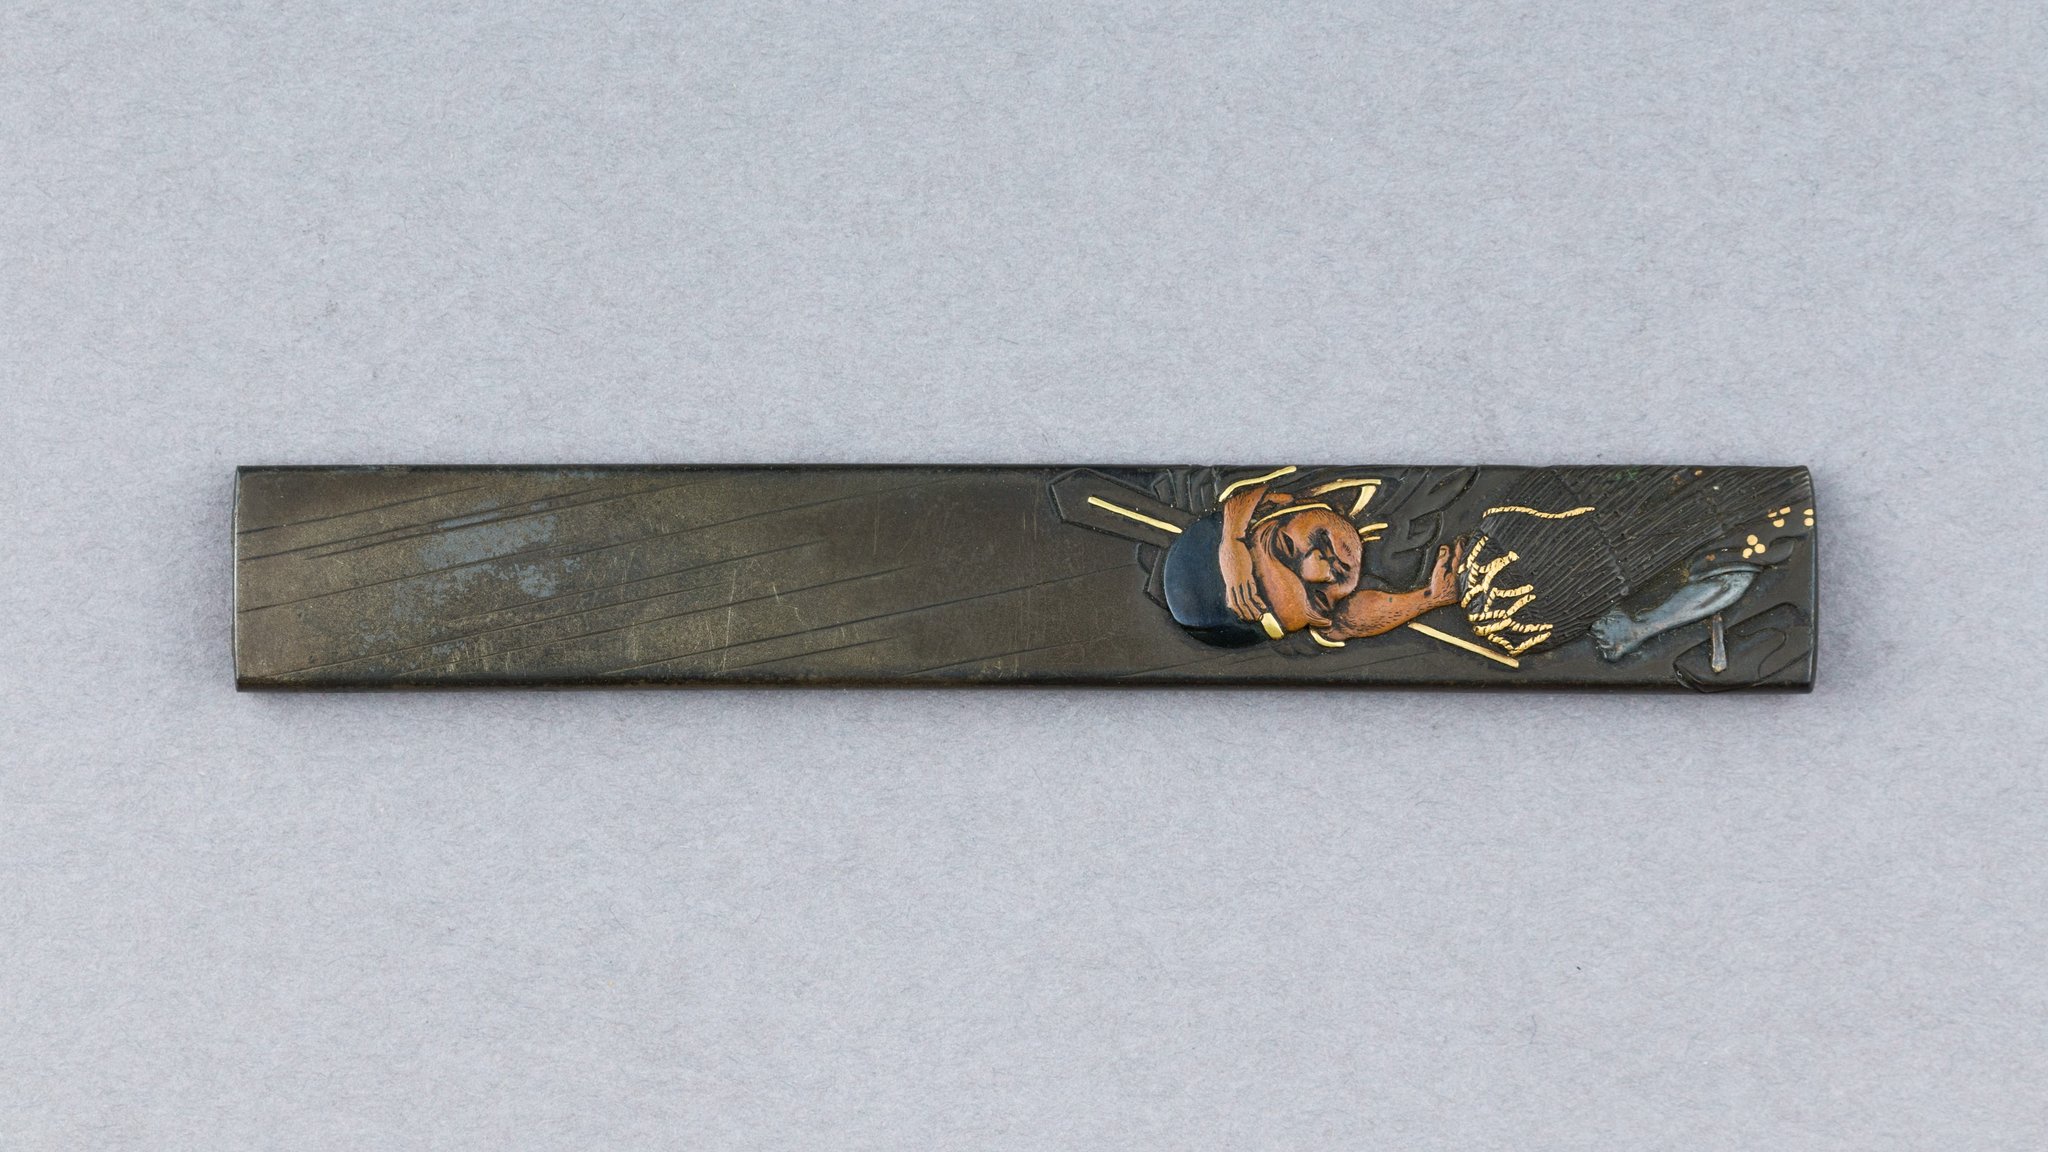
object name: knife handle kozuka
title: Knife Handle (Kozuka)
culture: japanese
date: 1615-1868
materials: copper, gold alloy, silver alloy, gold, silver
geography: japan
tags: men